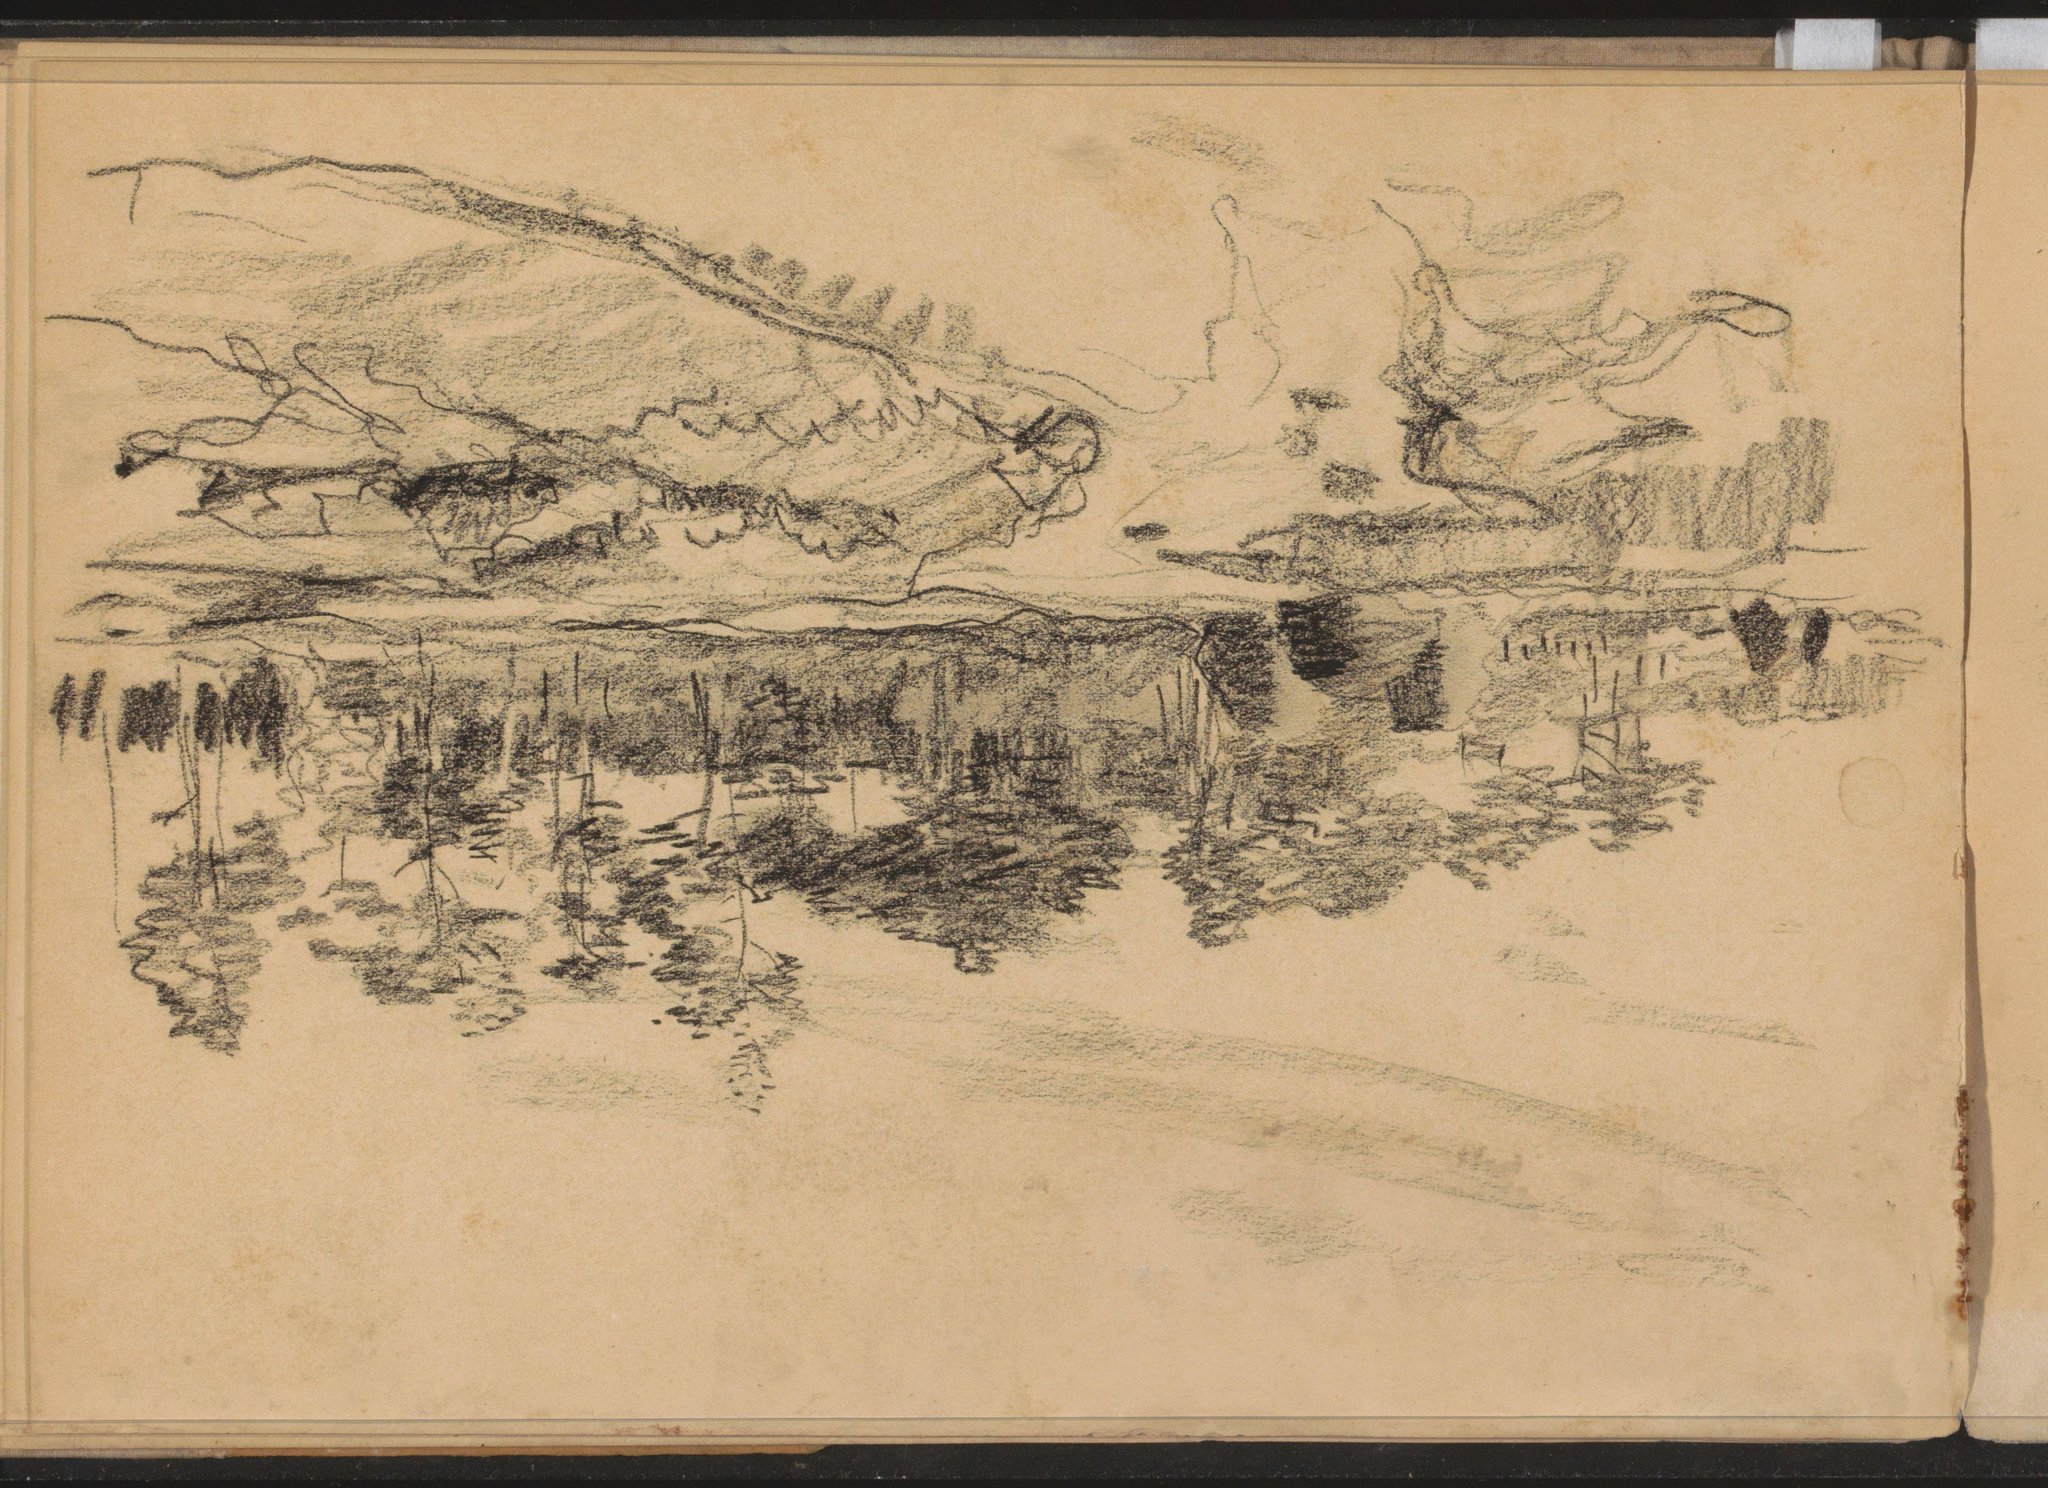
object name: sketchbook leaf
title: Pad richting een groep bomen, mogelijk op of in de omgeving van landgoed Ewijckshoeve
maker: willem bastiaan tholen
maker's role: draughtsman, painter, print maker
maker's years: 1860-1931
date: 1885-1931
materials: chalk, paper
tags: trees, landscapes, road, path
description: Blad 18 verso uit een schetsboek met 28 bladen.